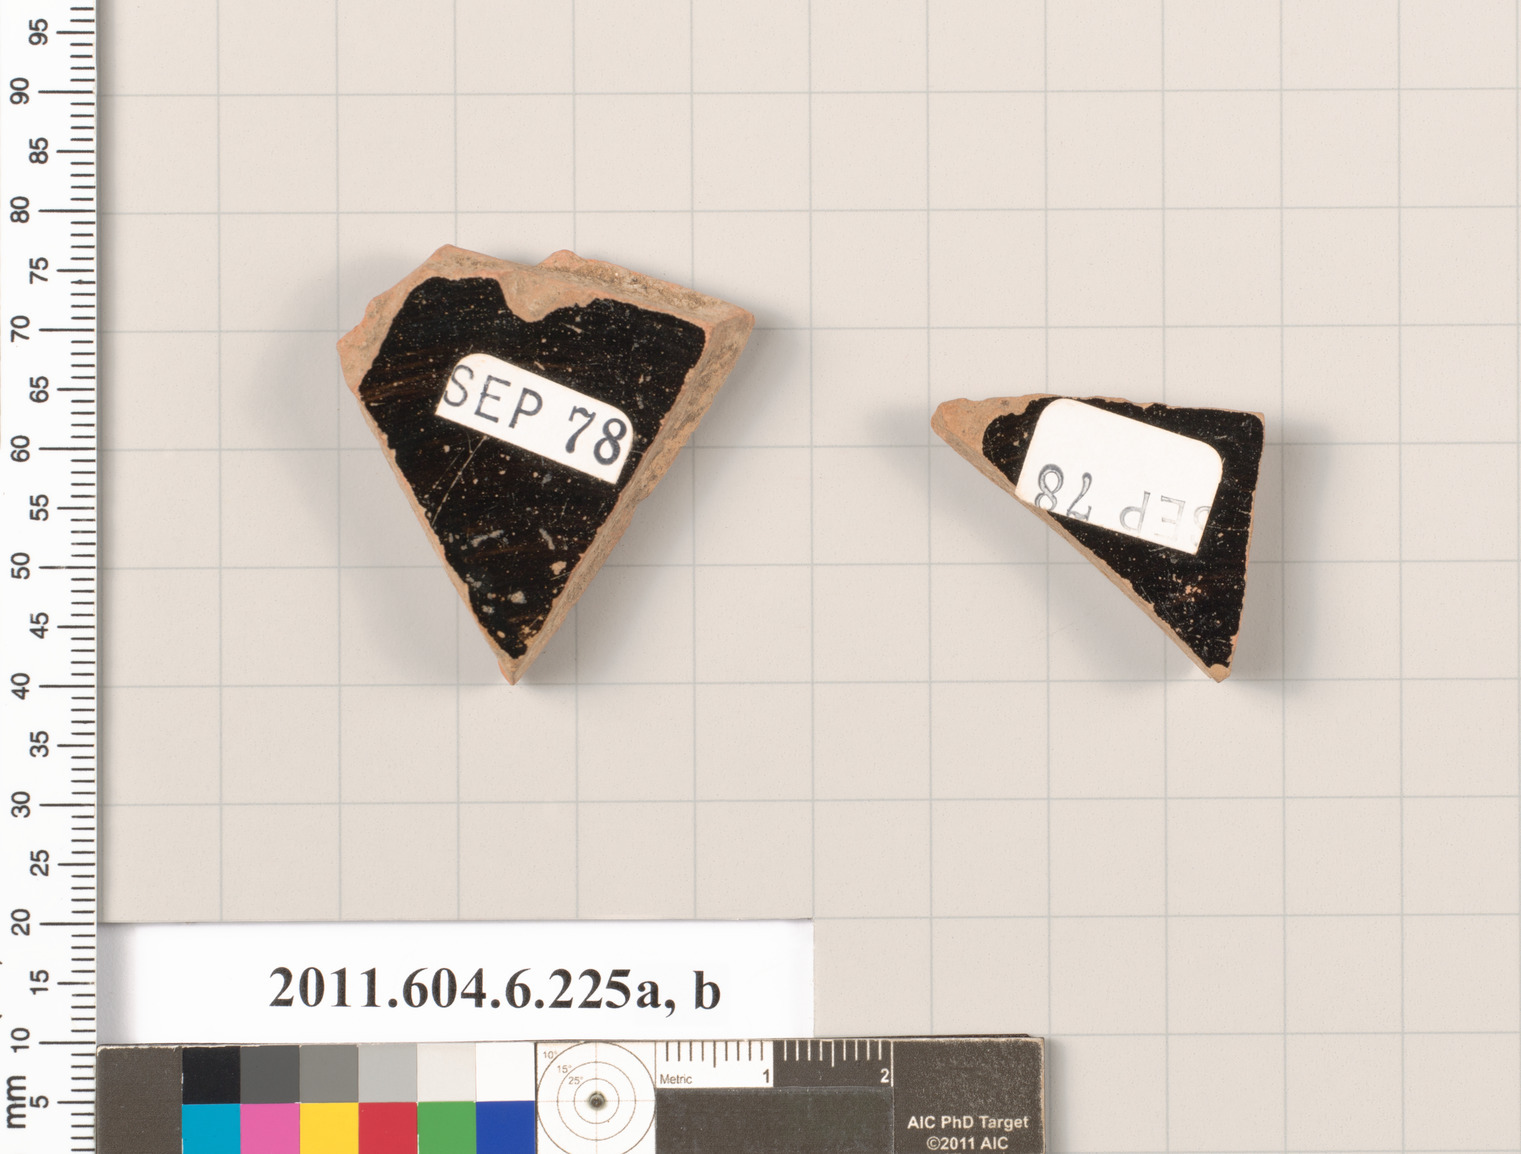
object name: undetermined open shape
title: Terracotta fragments of open shapes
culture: greek, attic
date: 600-401 BCE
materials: terracotta